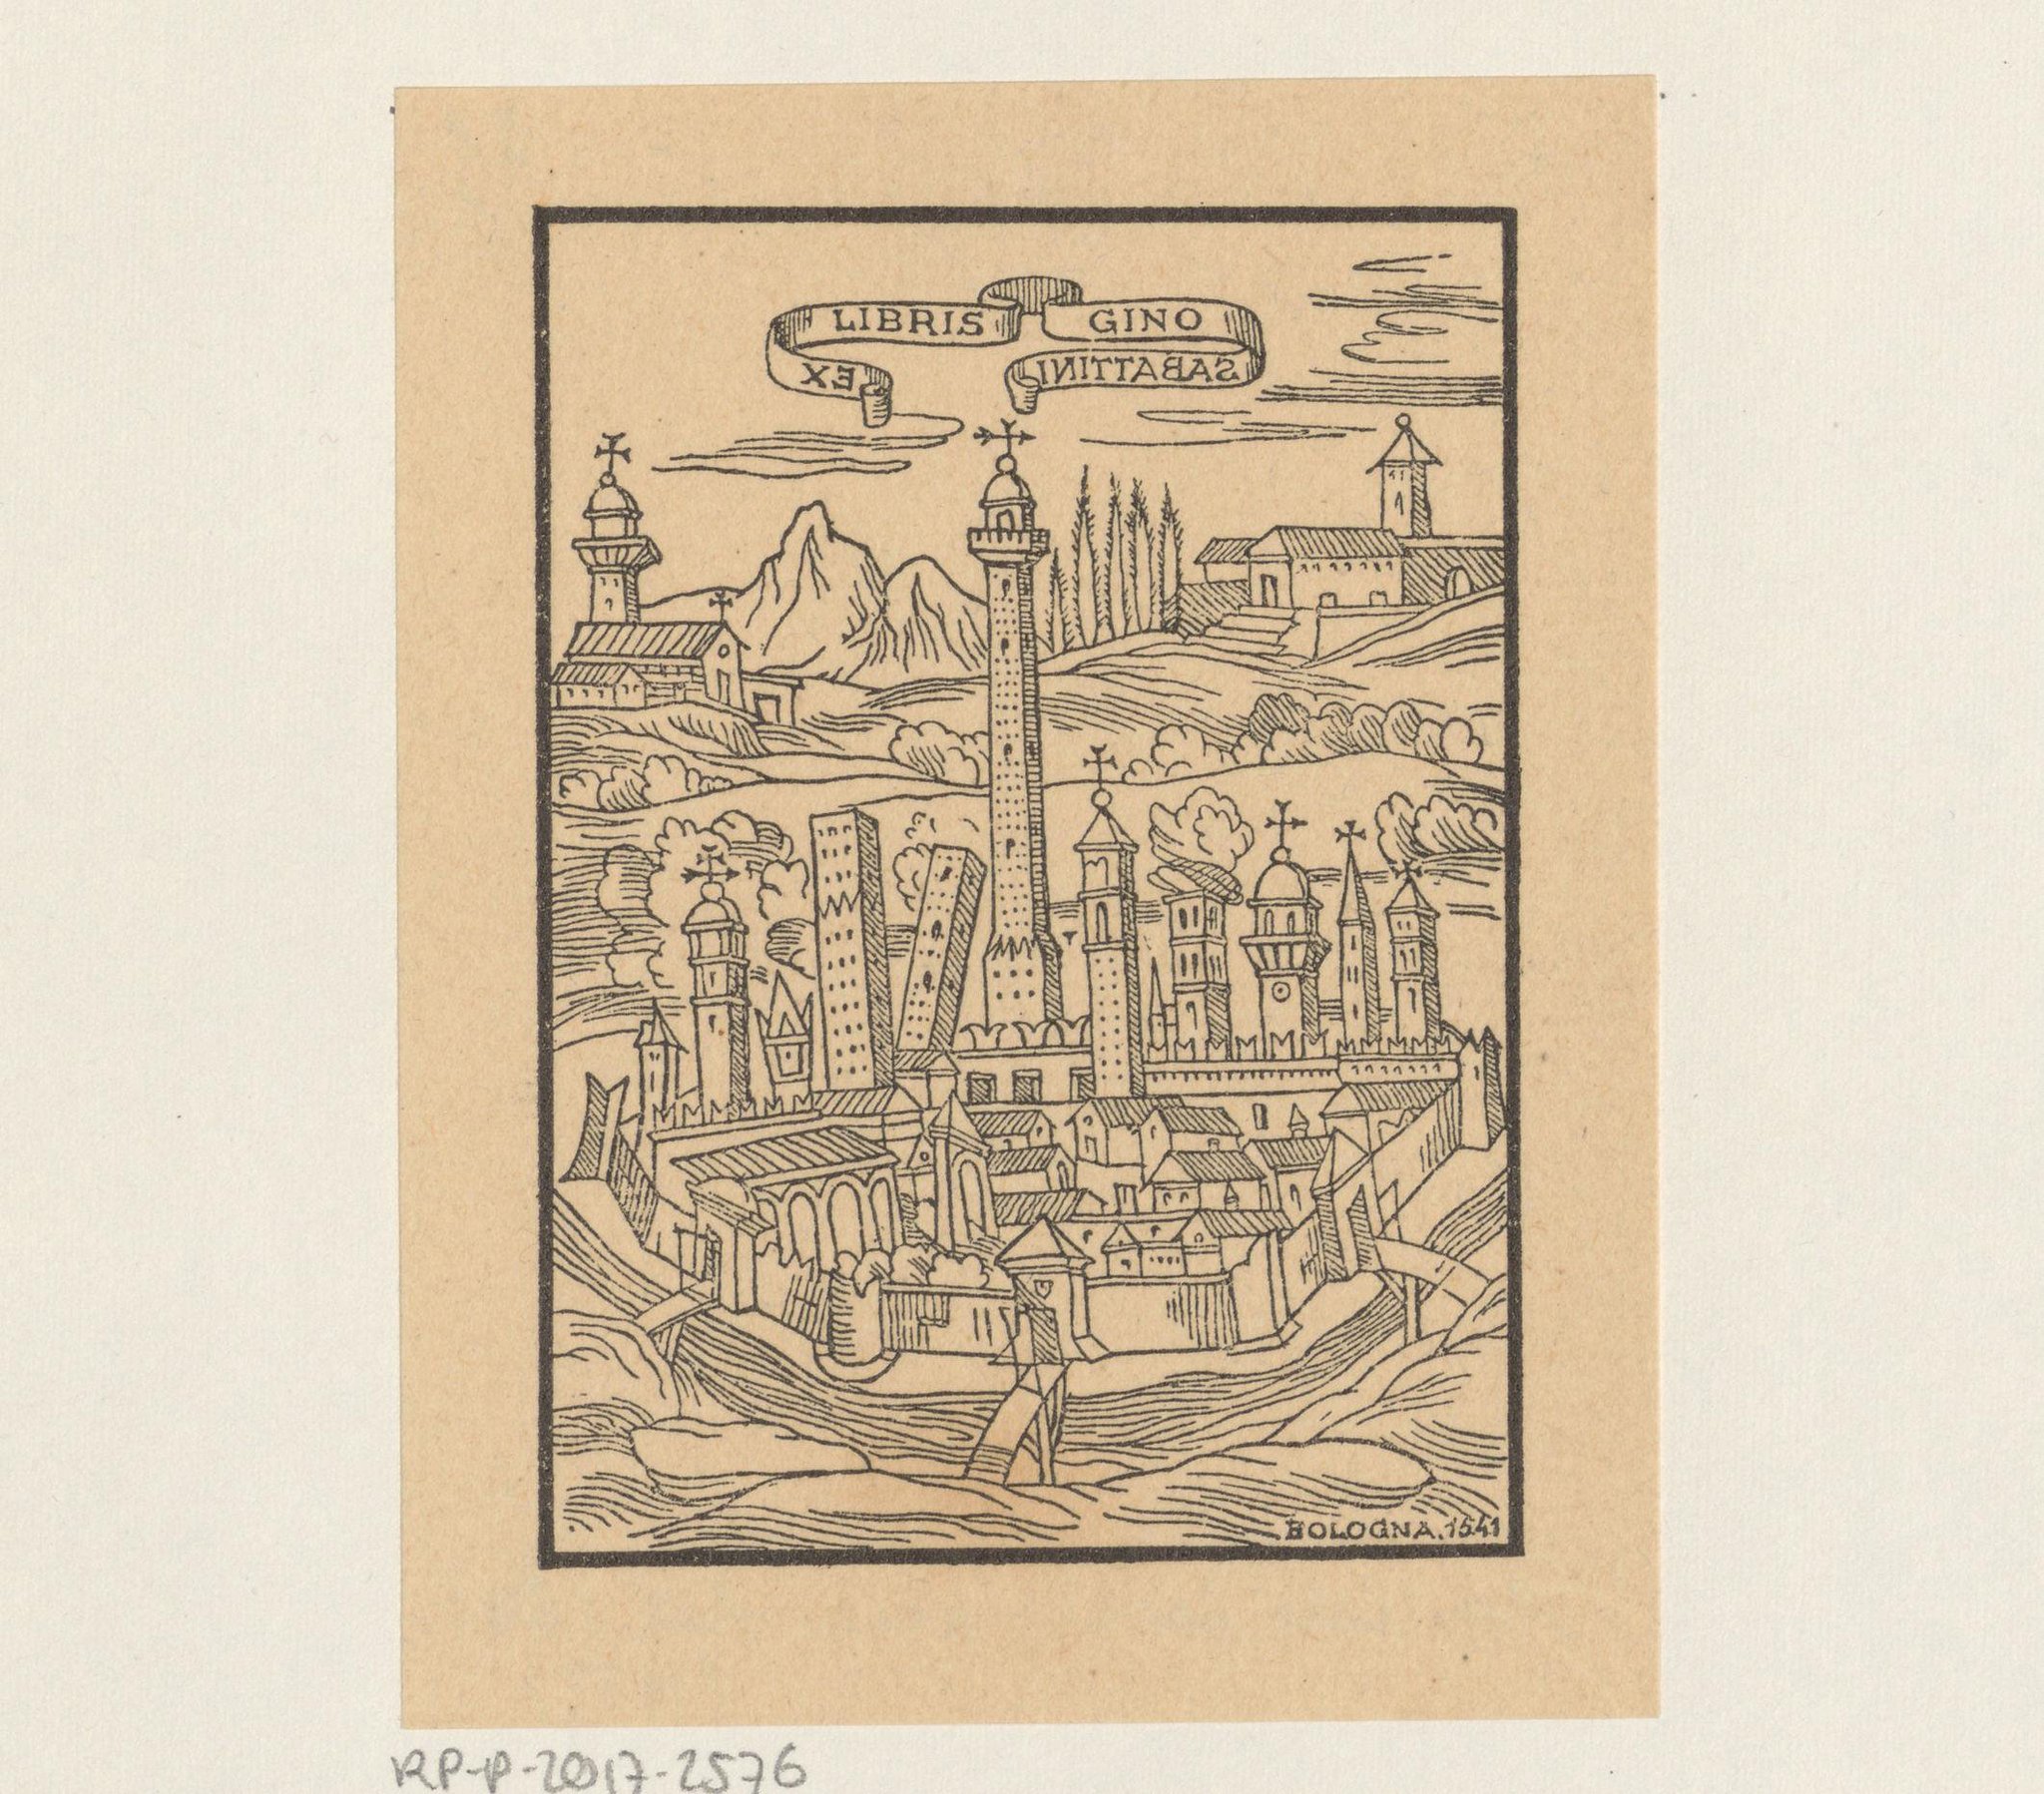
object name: bookplate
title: Ex libris van Gino Sabattini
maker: Anonymous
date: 1937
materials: paper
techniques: printing block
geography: bologna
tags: gino sabattini, tower, clock tower ~ monumental adornment, church (exterior), prospect of city, town panorama, silhouette of city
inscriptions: inscription: ‘da una incisione del 1541 / (1937)’